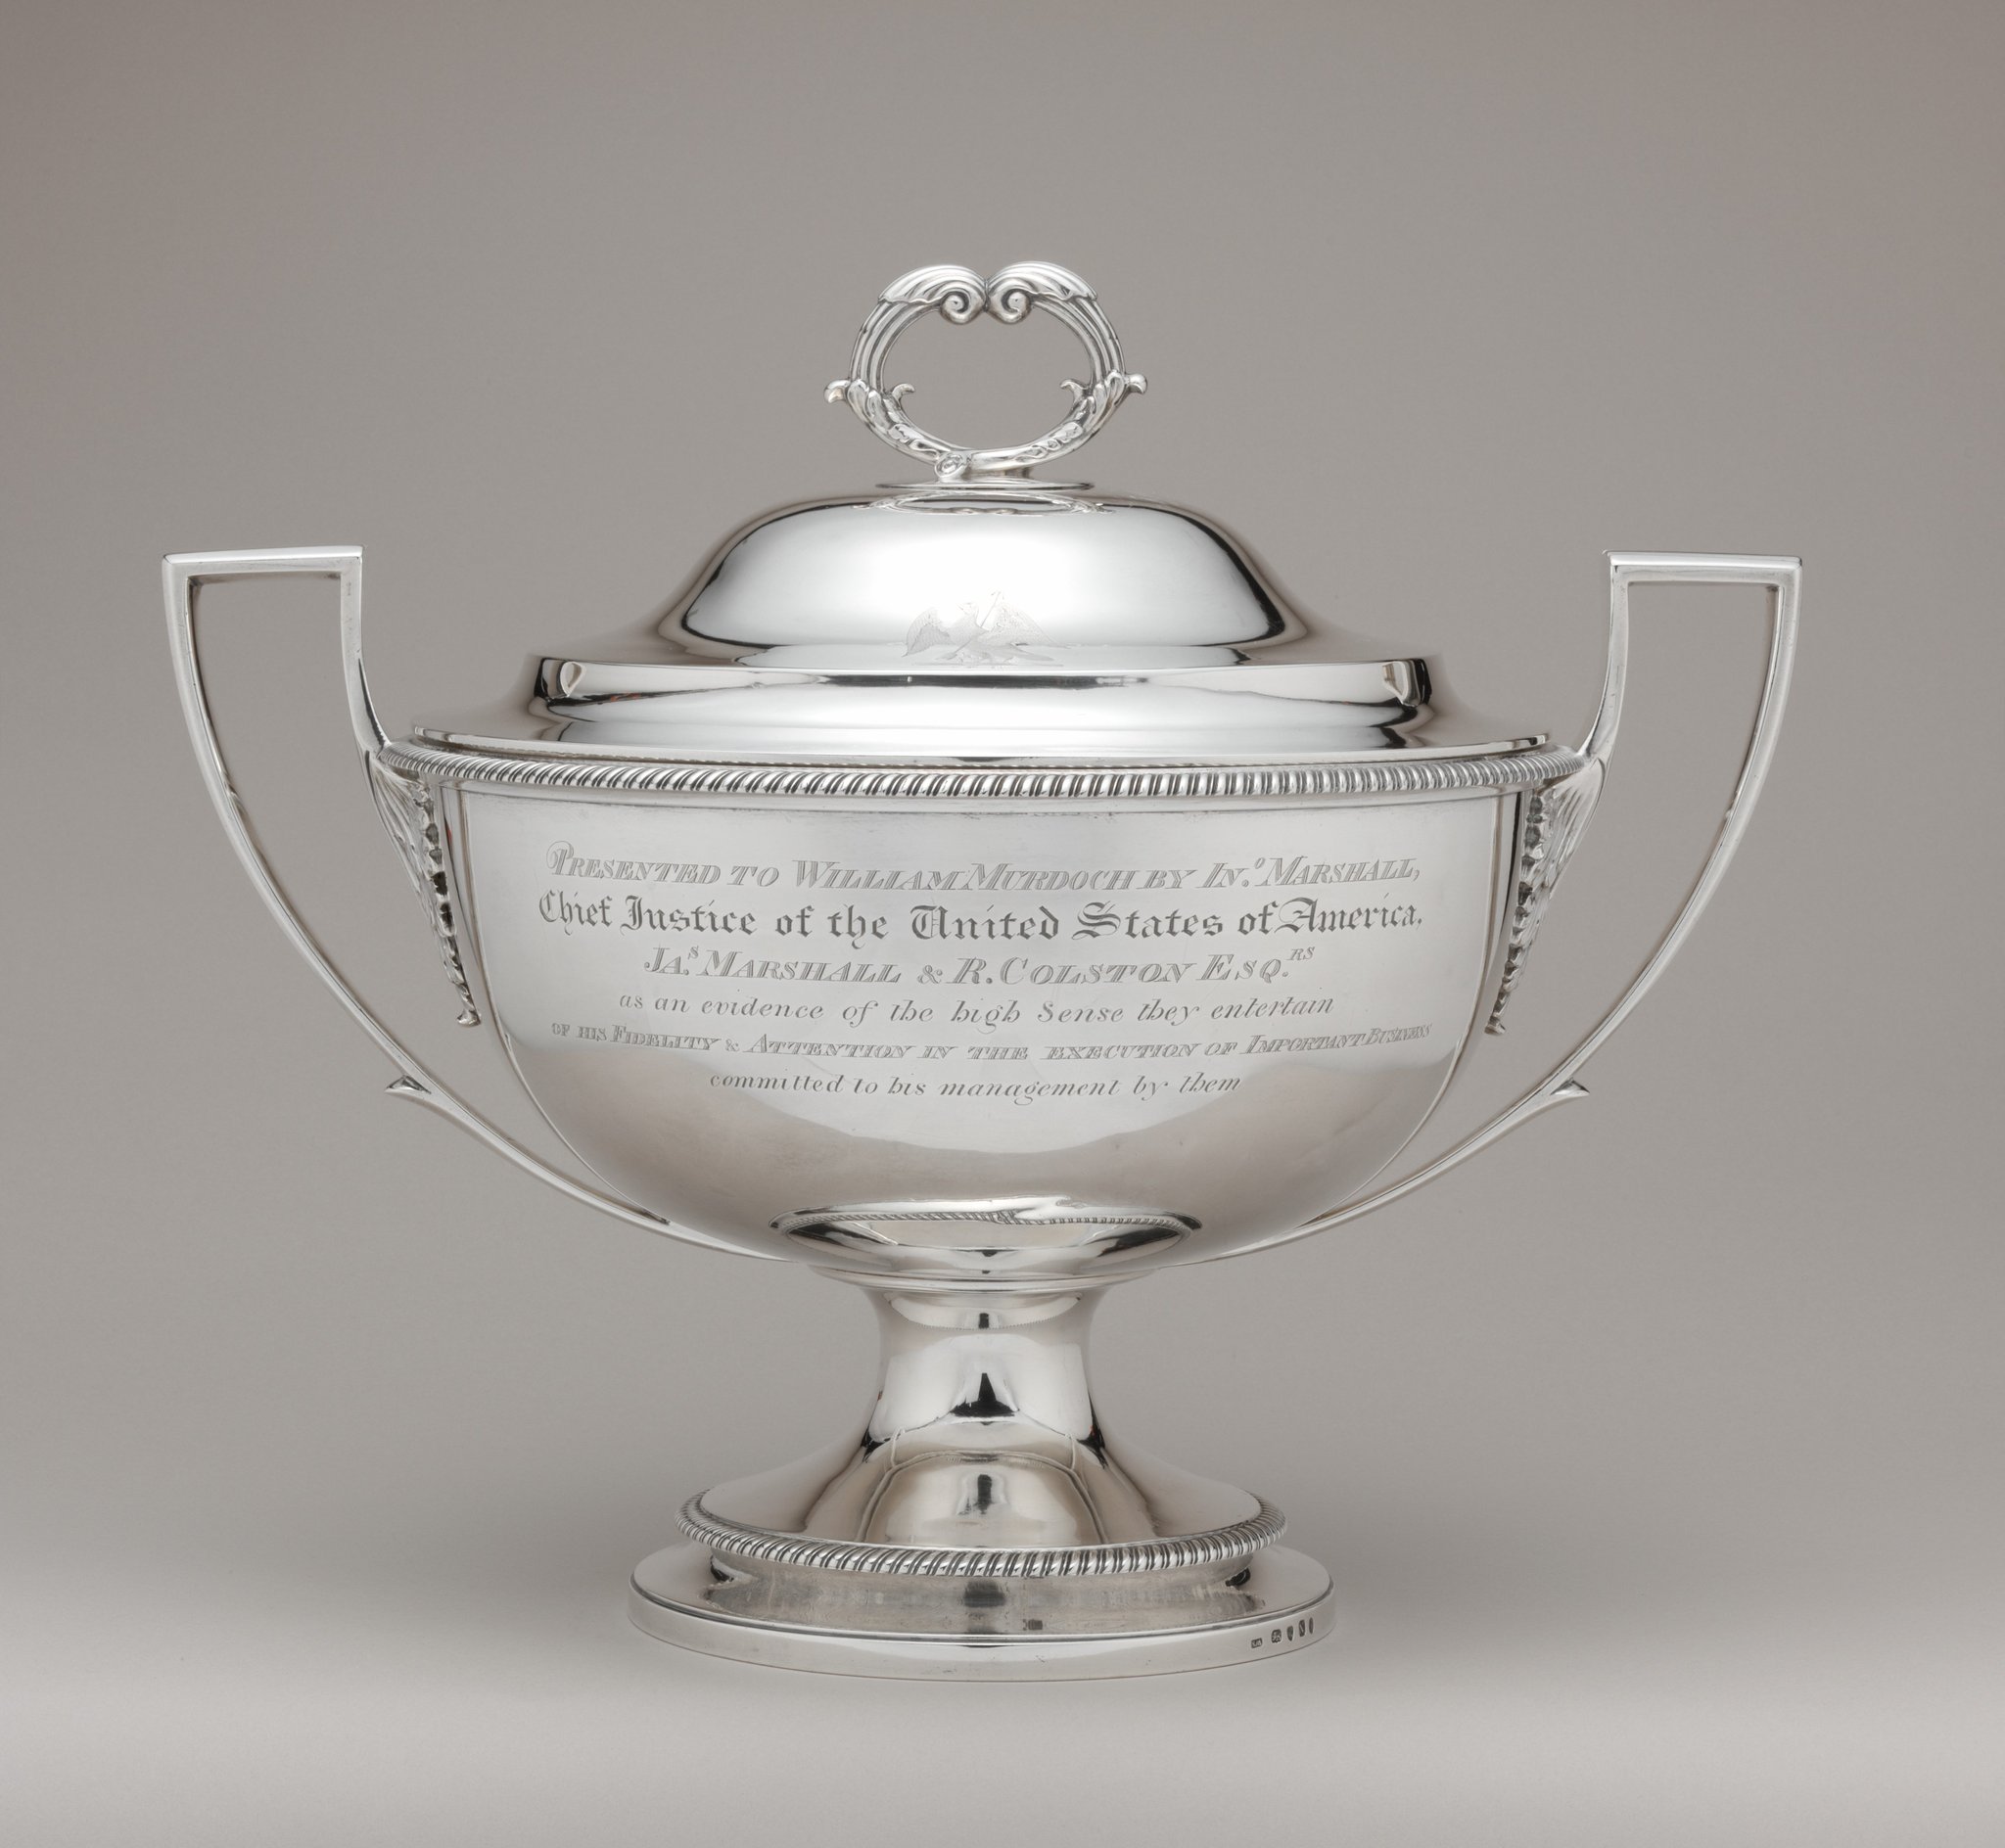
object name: soup tureen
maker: william stroude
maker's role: maker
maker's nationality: british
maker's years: 1788-1823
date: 1808-1809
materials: silver